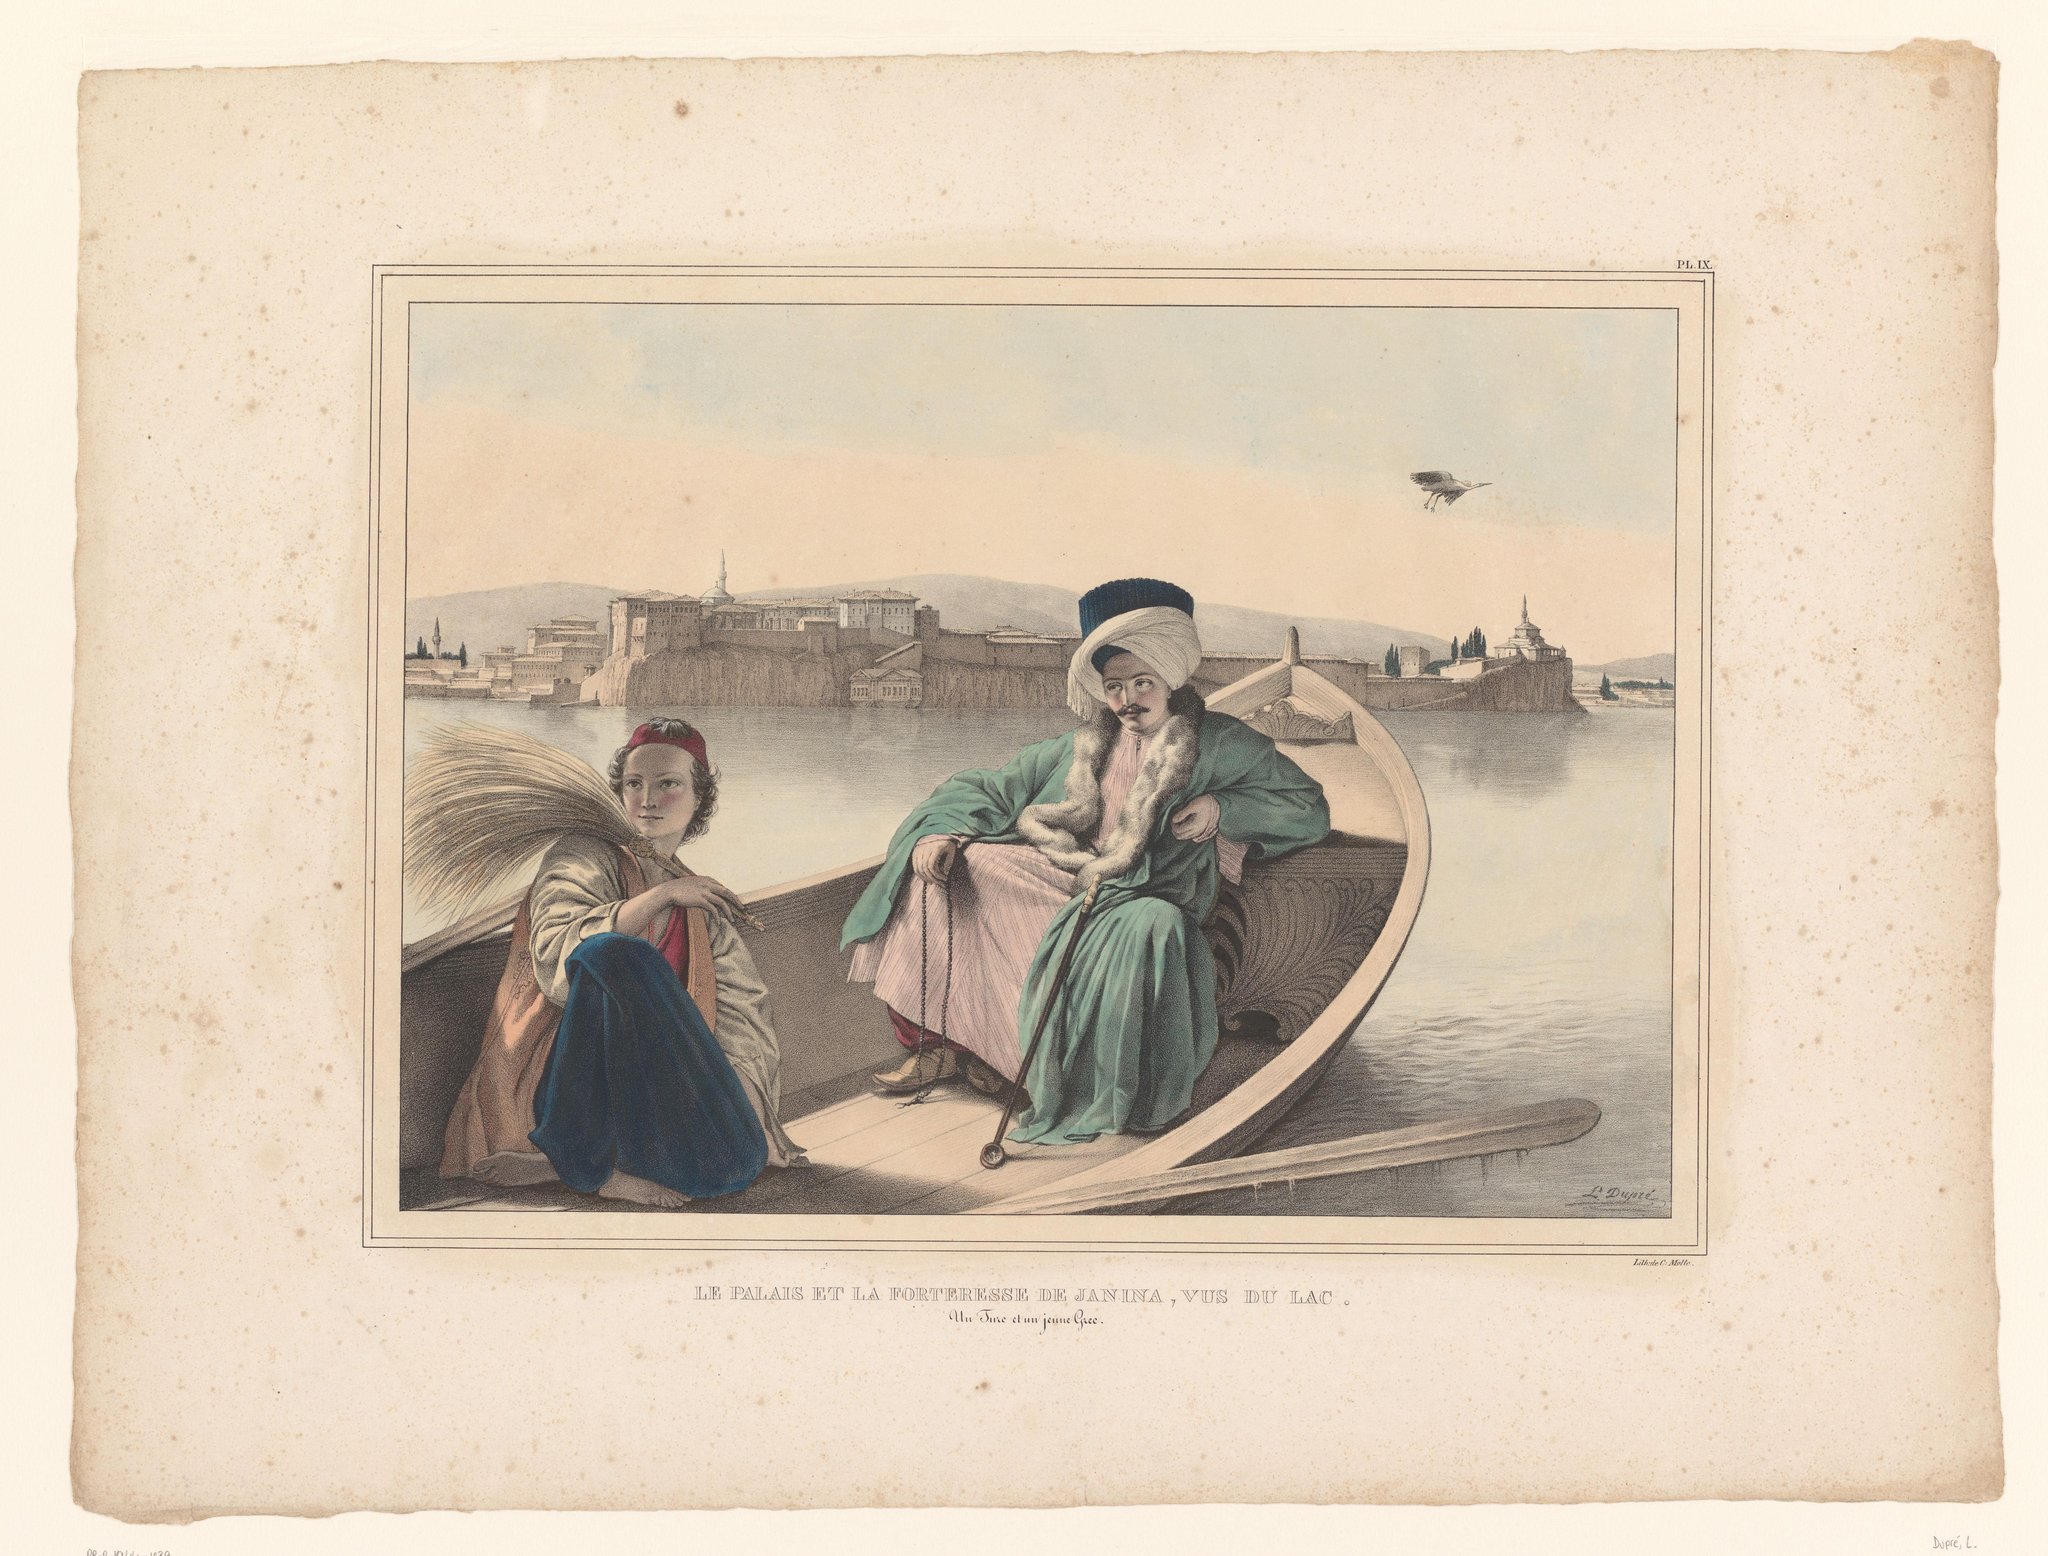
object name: print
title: Reis naar Athene en Constantinopel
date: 1825-1837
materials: paper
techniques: hand coloring, lithograph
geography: paris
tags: fortress, asiatic races and peoples: turks, europeans (with name), palace, rowing-boat, canoe, etc.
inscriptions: watermark: ‘151’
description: De prent maakt deel uit van de serie 'Voyage à Athènes et à Constantinople ou collection de portraits, de vues et de costumes Grecs et Ottomans' die tussen 1825 en 1839 in tien delen van vier prenten werd uitgebracht. De in totaal veertig prenten dienden samen met een tekst van 52 pagina's voorzien van vignettes als een verslag van de reis die Louis Dupré in 1819 naar Athene en het huidige Istanboel maakte (zie documentatie).